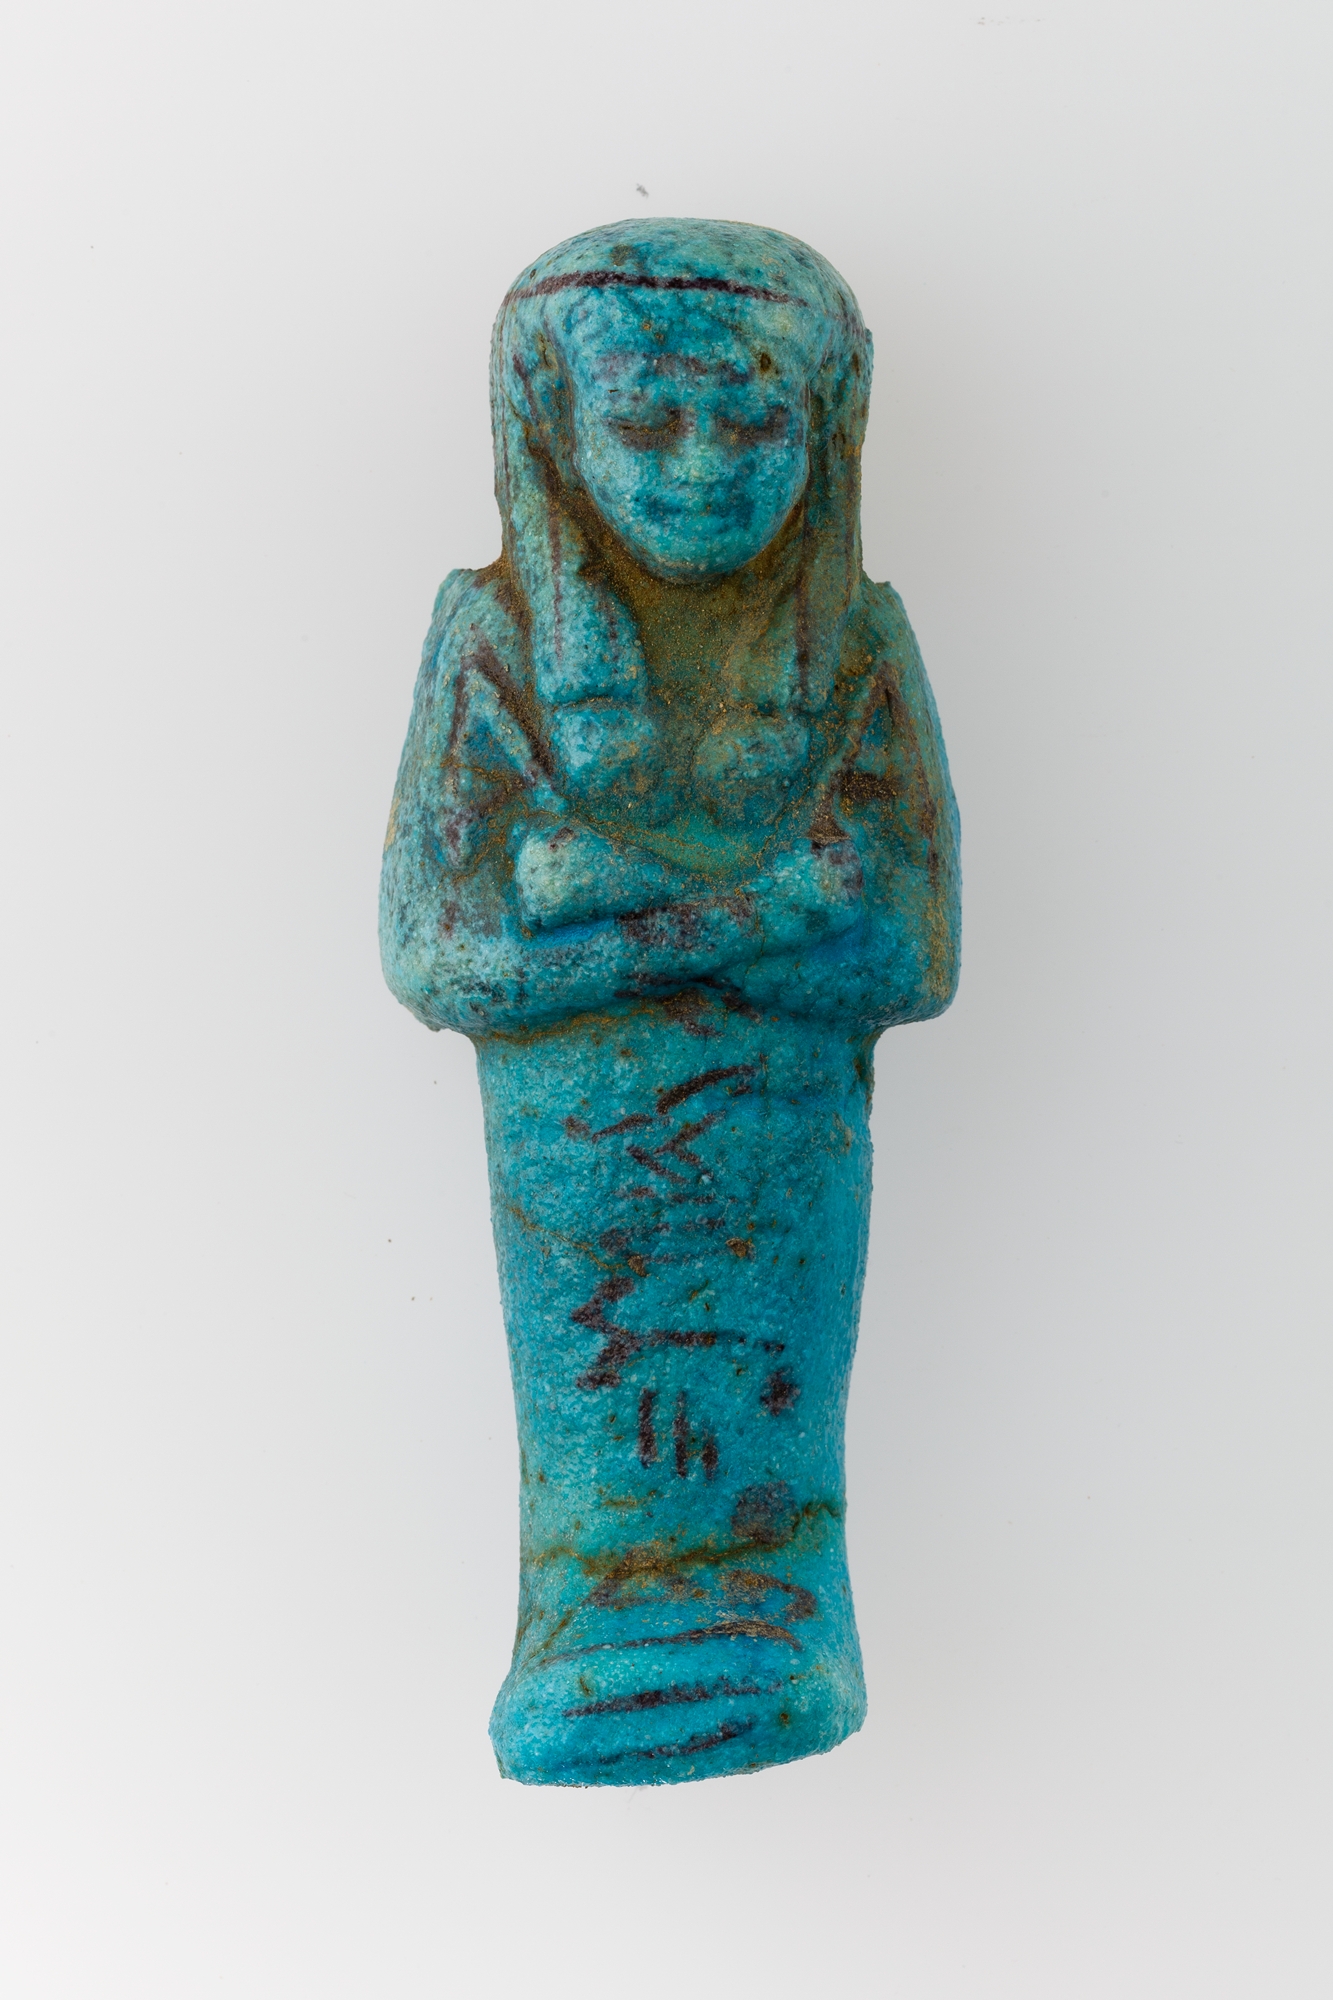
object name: shabti, henettawy c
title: Worker Shabti of Henettawy (C), Daughter of Isetemkheb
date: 990-970 BCE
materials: faience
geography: egypt